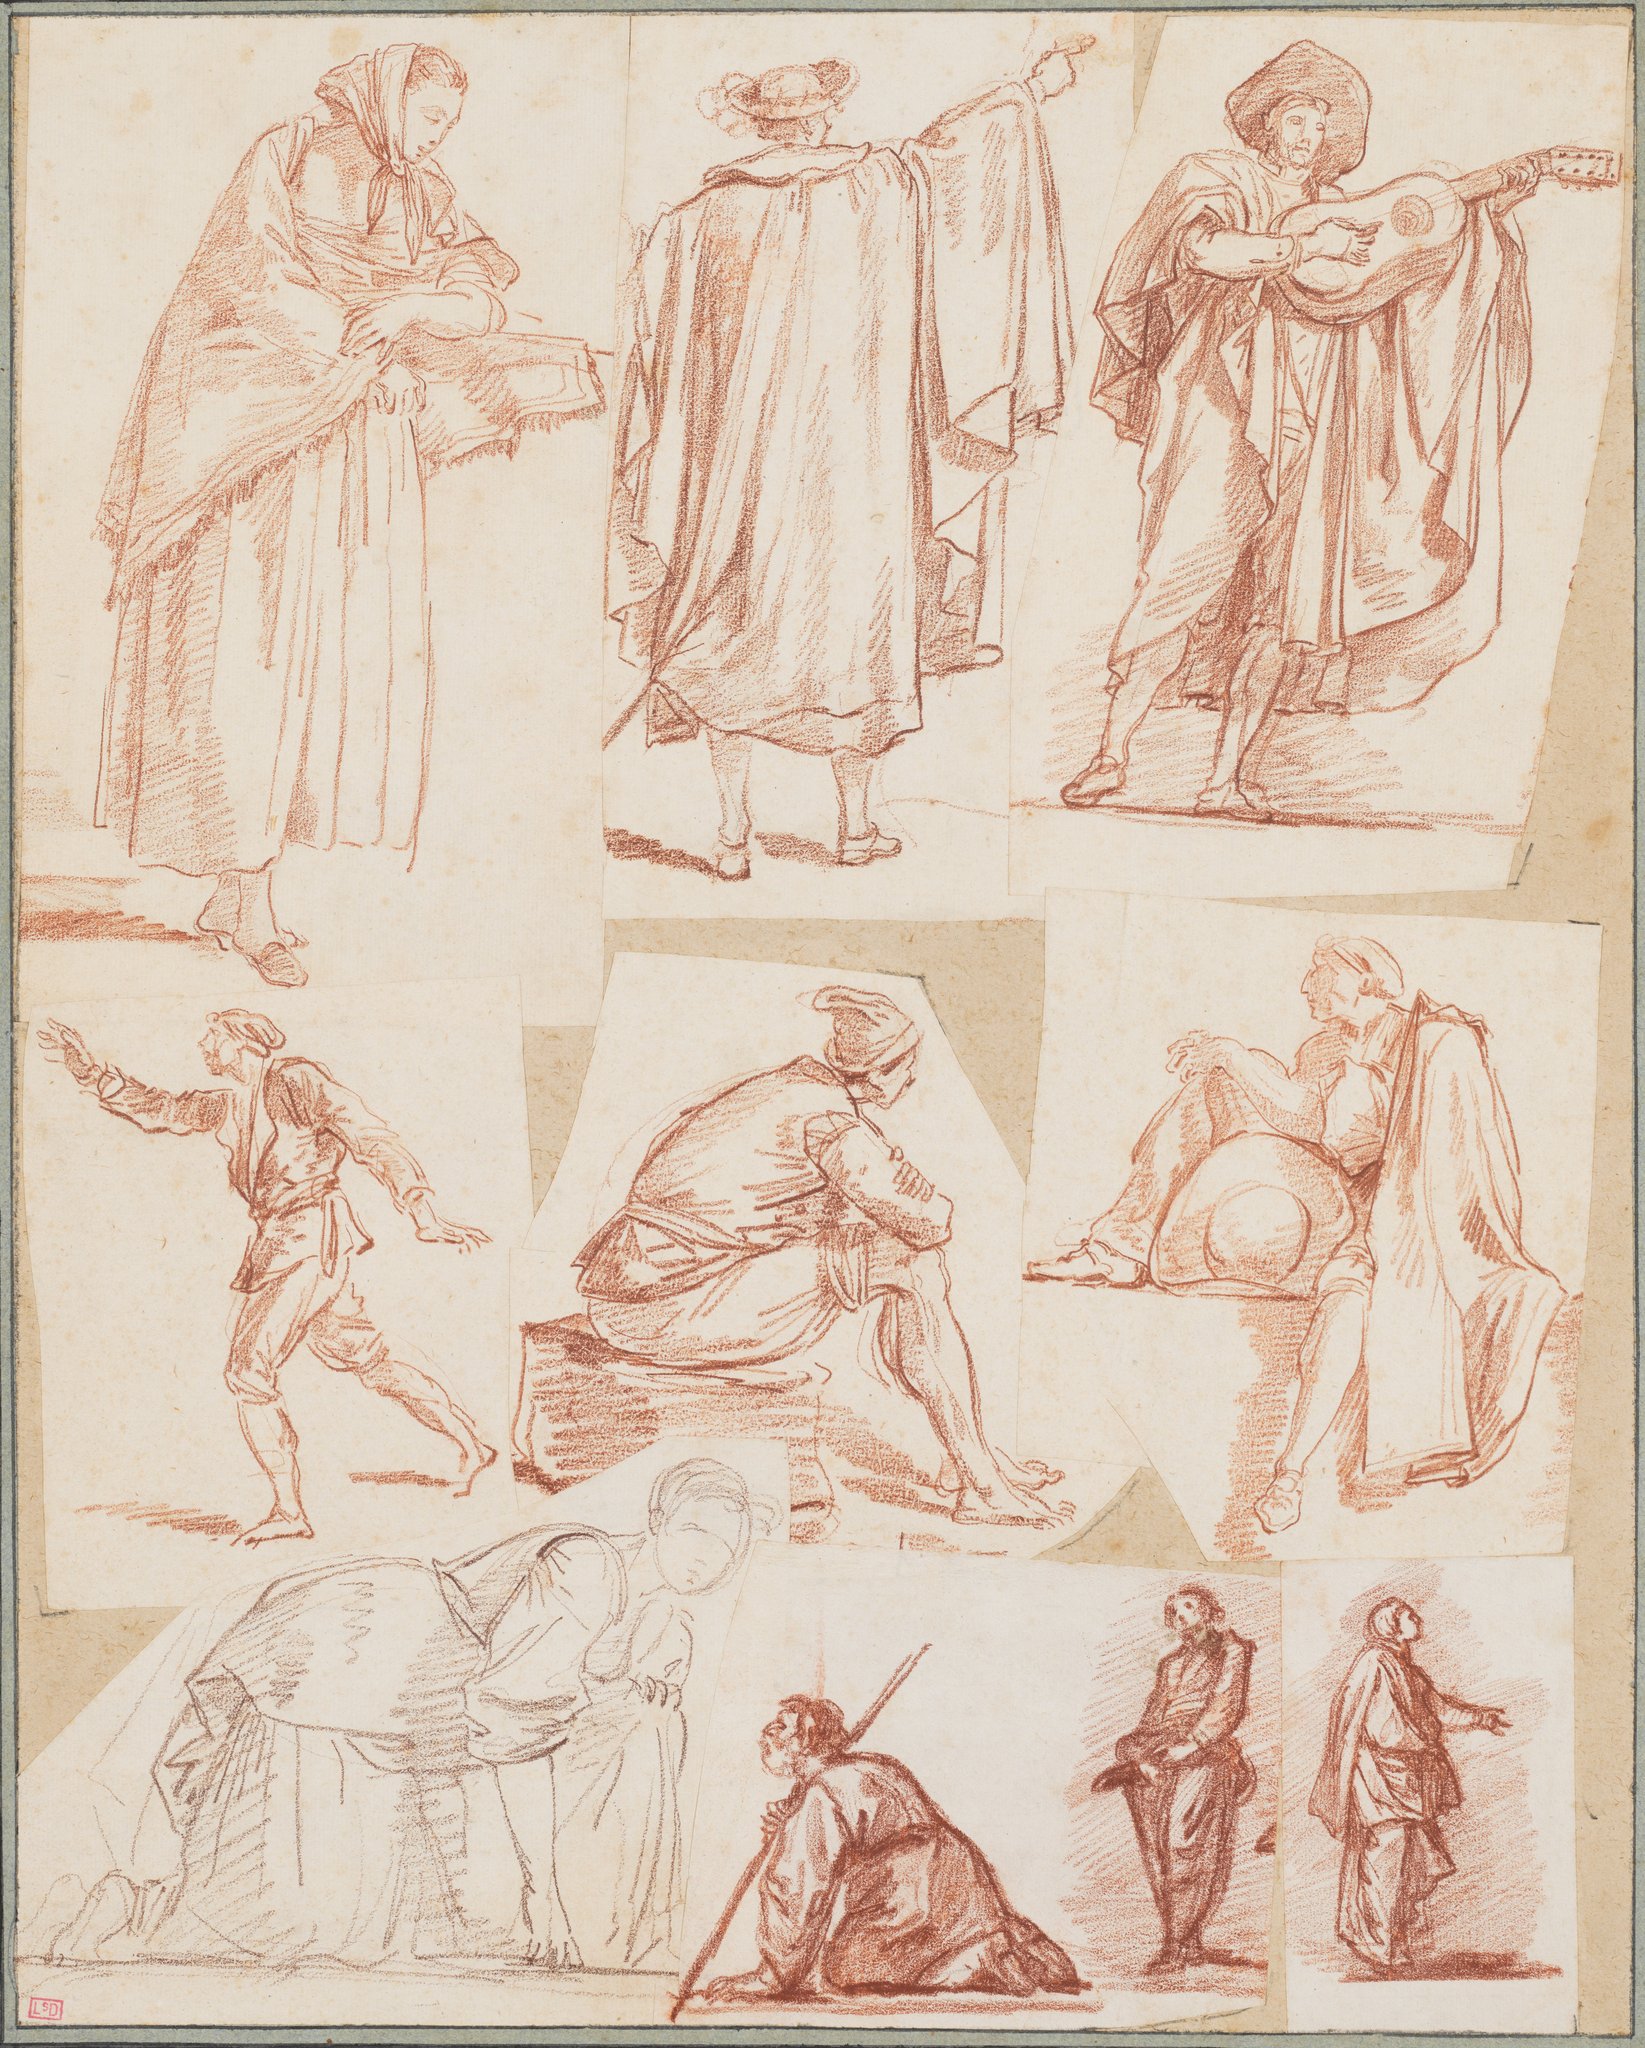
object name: drawing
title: Figure studies mounted on an album page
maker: hubert robert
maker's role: artist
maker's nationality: french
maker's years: 1733-1808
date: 1762-1765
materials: chalk